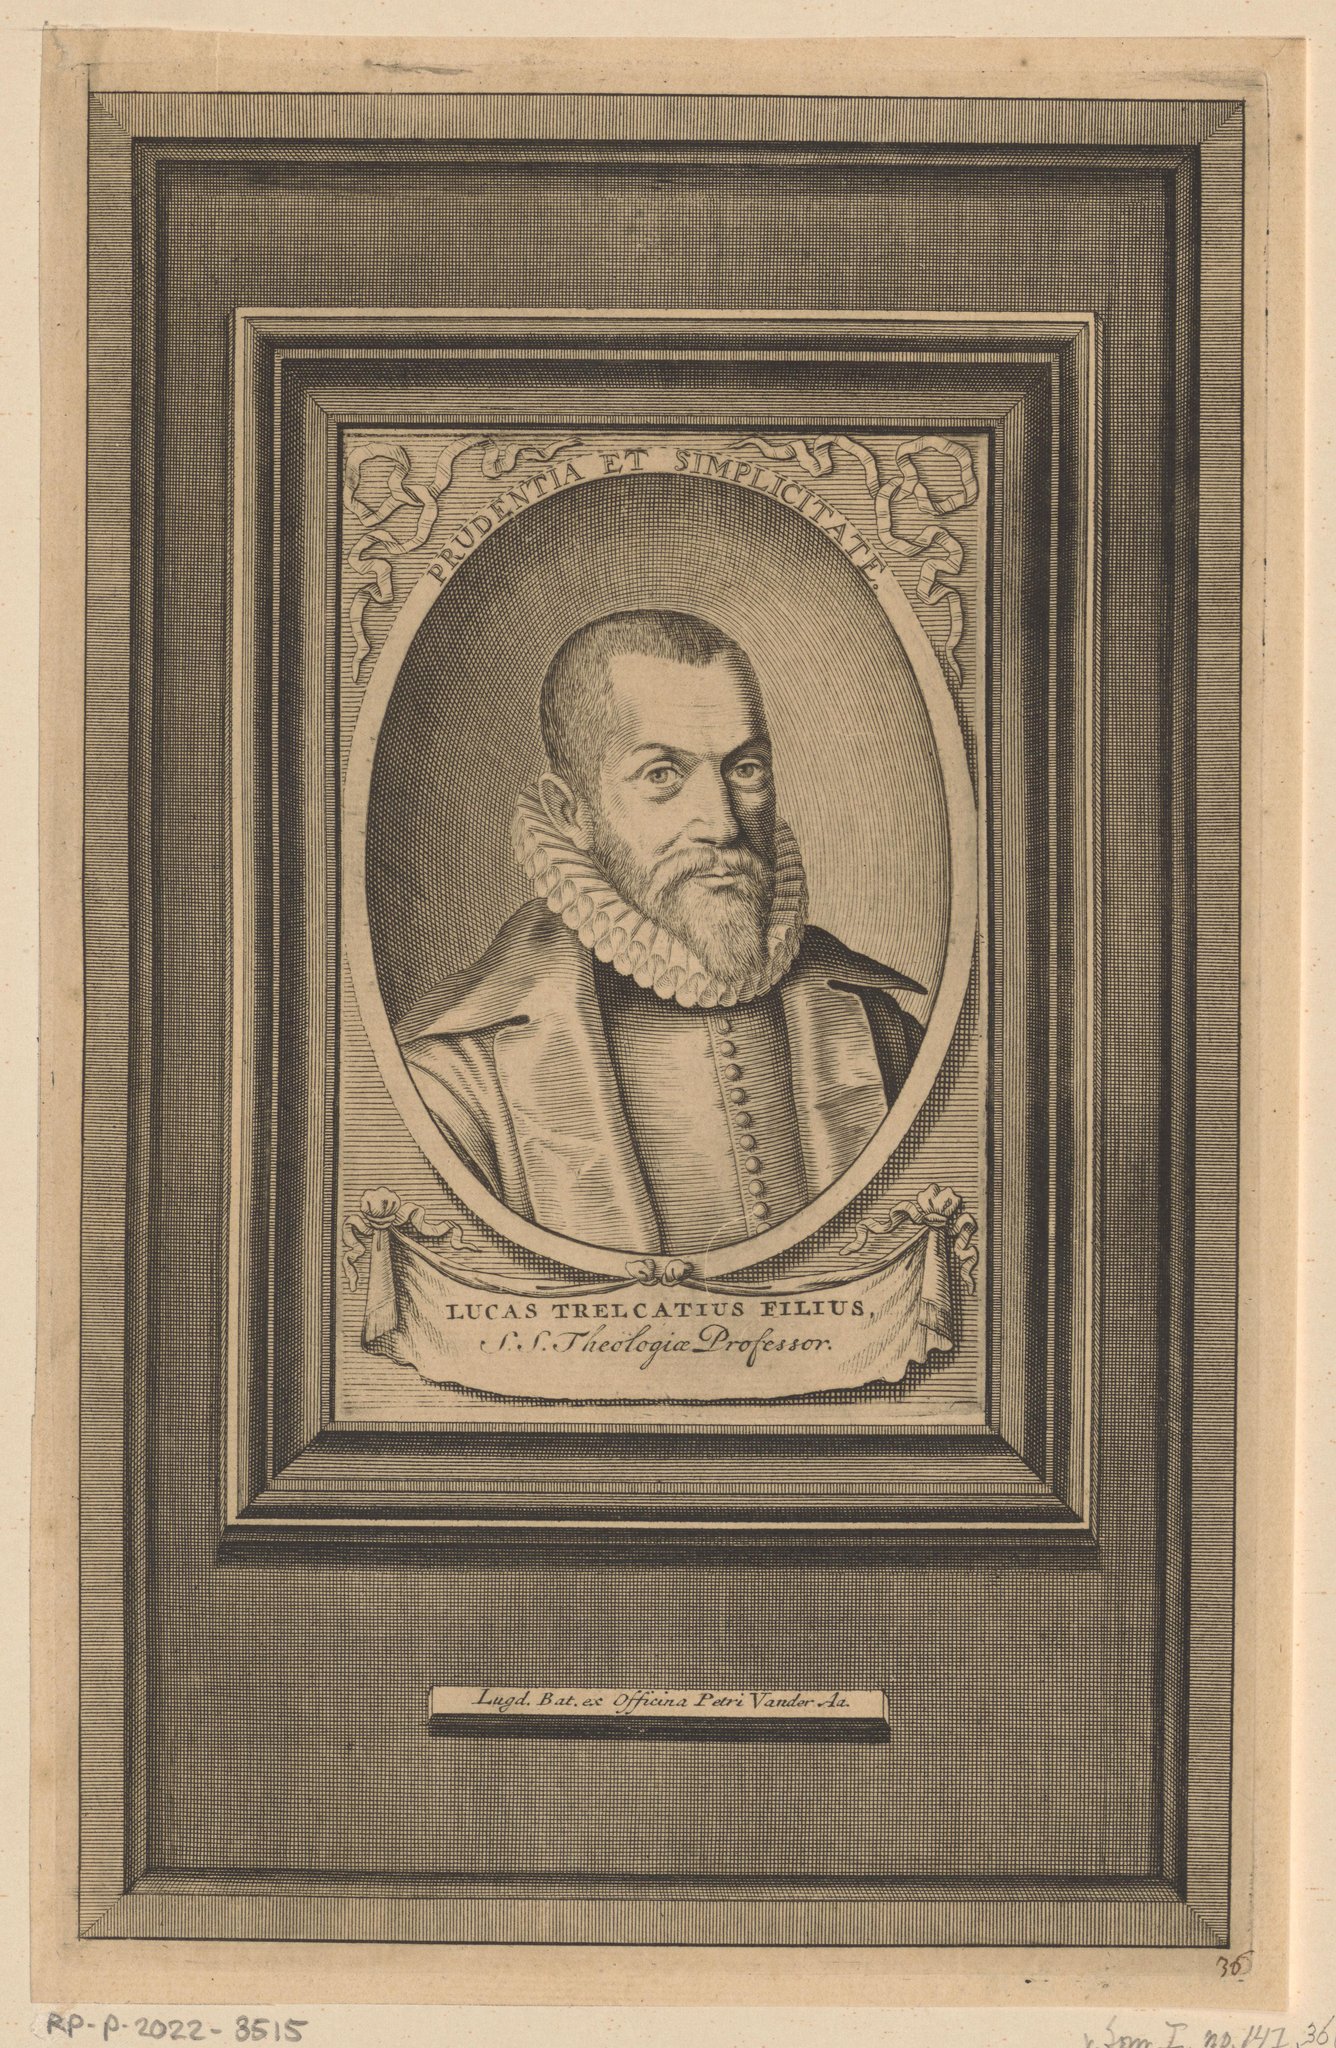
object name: print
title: Portret van Lucas Trelcatius (II)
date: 1716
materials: paper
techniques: engraving, etching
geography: leiden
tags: london, theologian, scholar, philosopher, historical persons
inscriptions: number: ‘36’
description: Met omlijsting gedrukt van een aparte plaat, rechtsonder genummerd: 36.